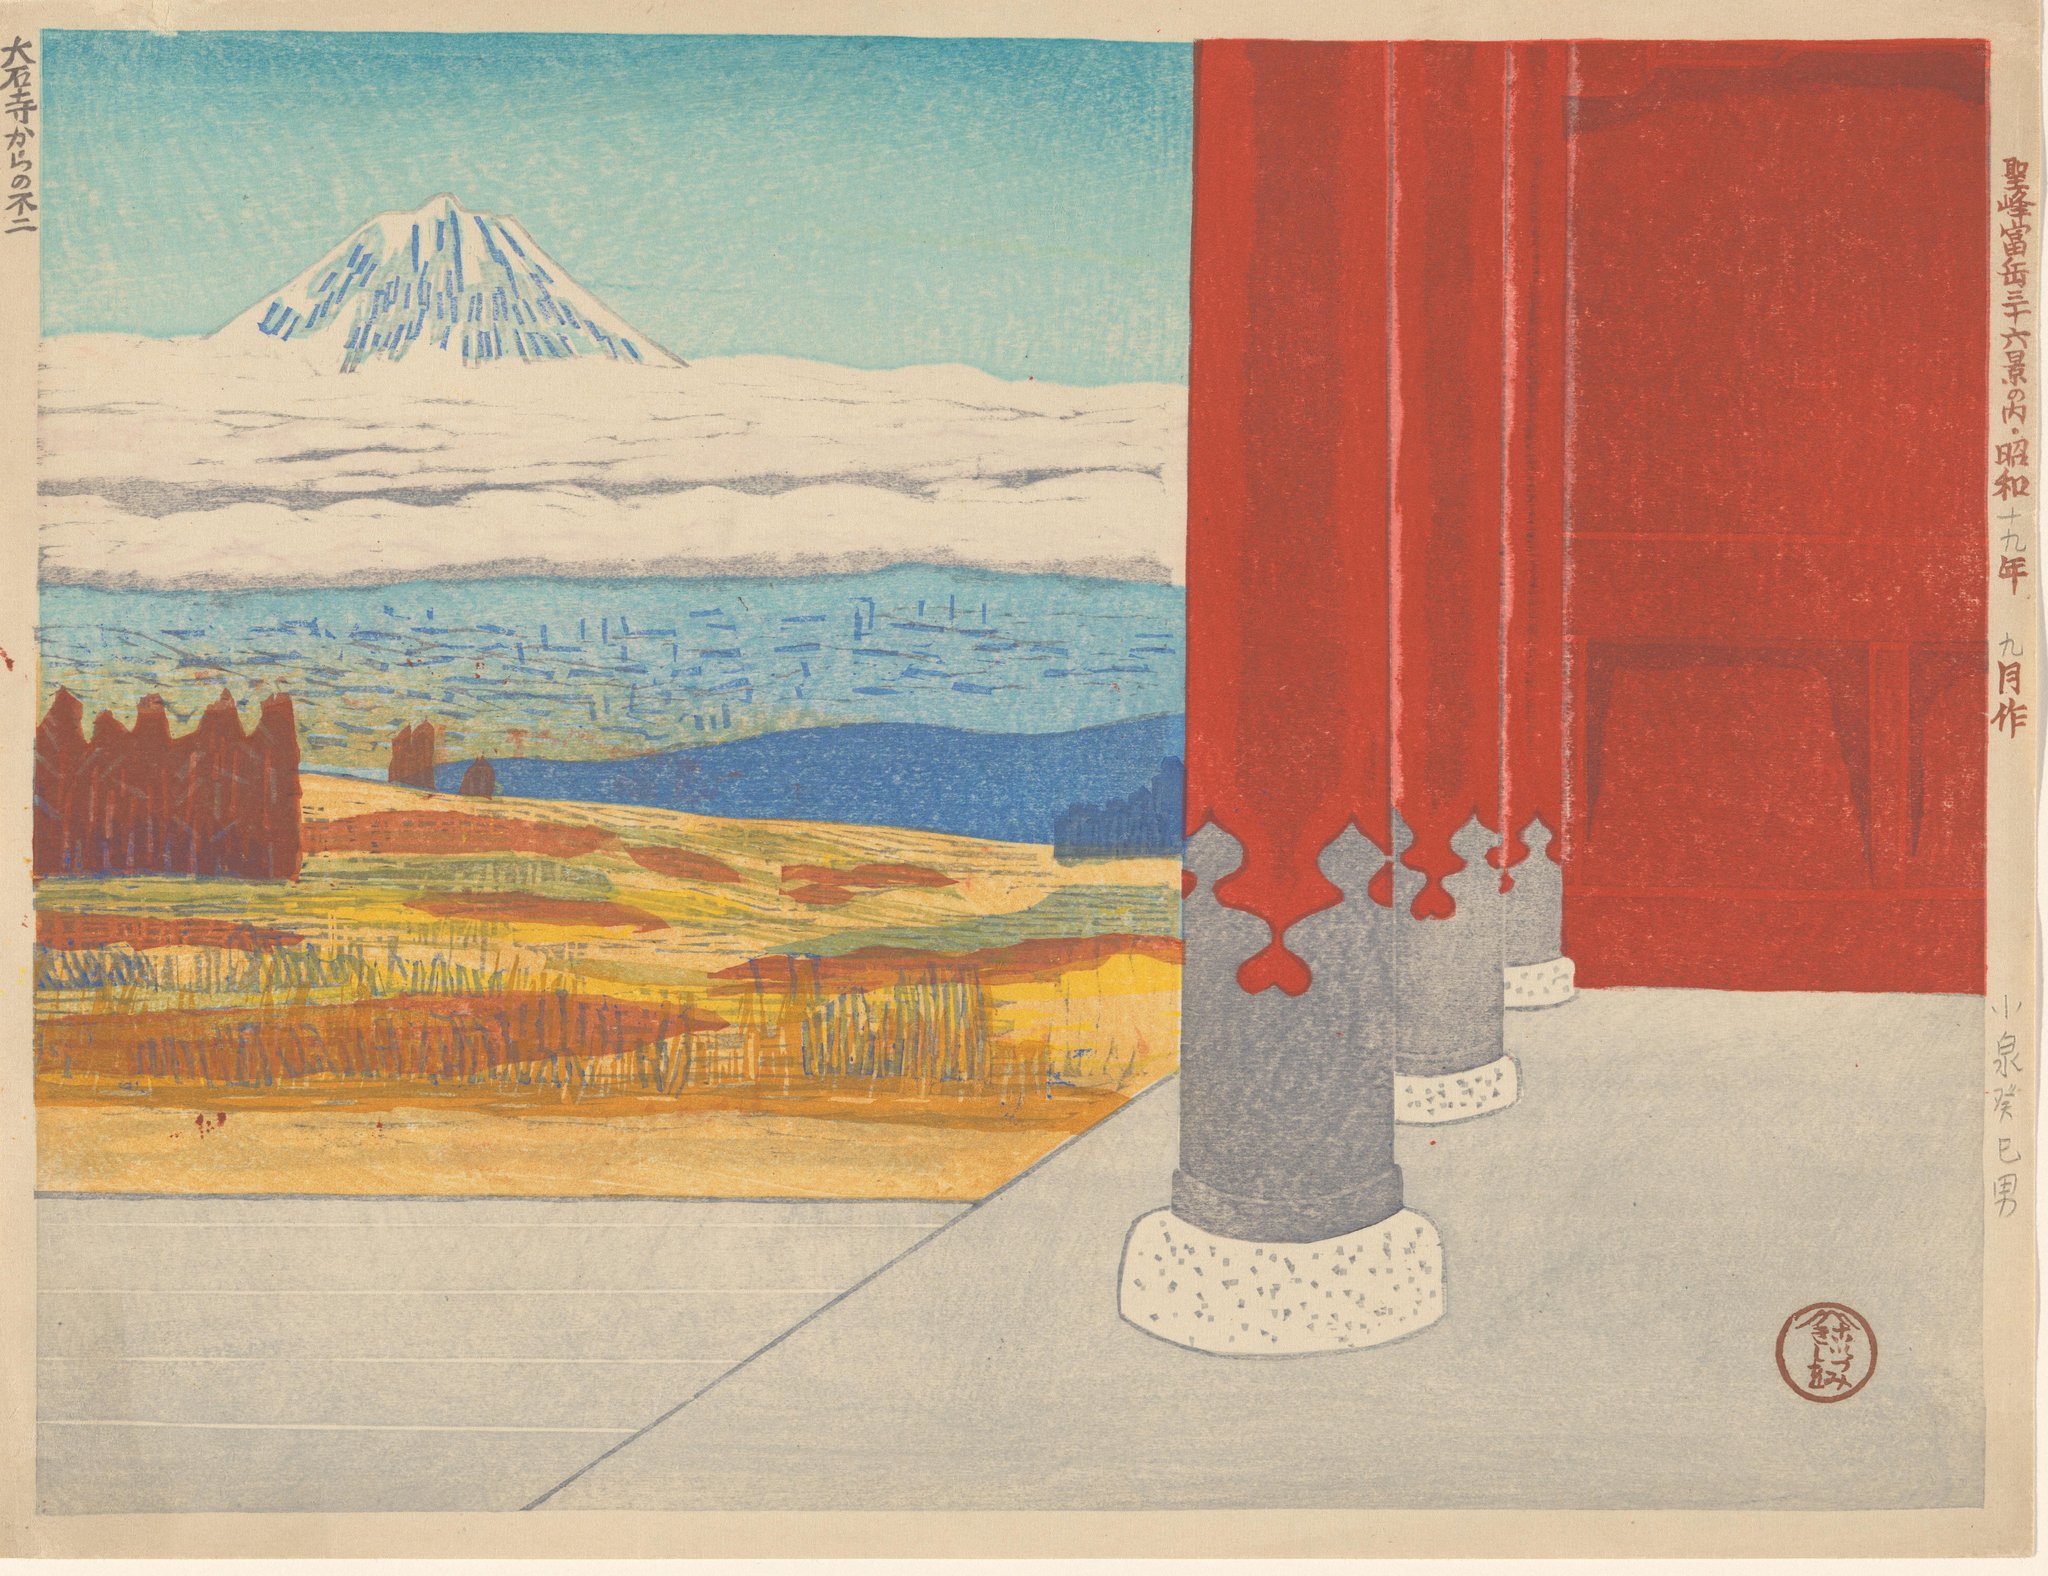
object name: print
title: Taisekiji kara no Fuji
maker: koizumi kishio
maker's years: 1893-1945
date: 1909-1944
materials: paper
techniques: woodcut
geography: japan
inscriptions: seal: ‘こいづみきしを’, signature: ‘小泉癸巳男’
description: De rode kleur van de steunpilaren van de sanmon-tempelpoort bij de Taiseki-tempel geeft een mooi contrast met het blauw van de lucht en het geel van de velden in de verte. De piek van de Fuji-berg stijgt uit boven een dik wolkendek. De Taiseki-tempel ligt direct ten zuidwesten van de Fuji-berg. Koizumi Kishio begon in 1940 aan zijn project 'Zesendertig gezichten op de heilige berg Fuji', een knipoog naar de welbekende prenten uit de jaren 1830 van Katsushika Hokusai (1760–1849). Vanwege de geallieerde bombardementen vluchtte hij naar zijn schoonouders in Saitama, ten noorden van Tokyo. Hij voltooide 23 ontwerpen voor hij bezweek aan ziekte in 1945.